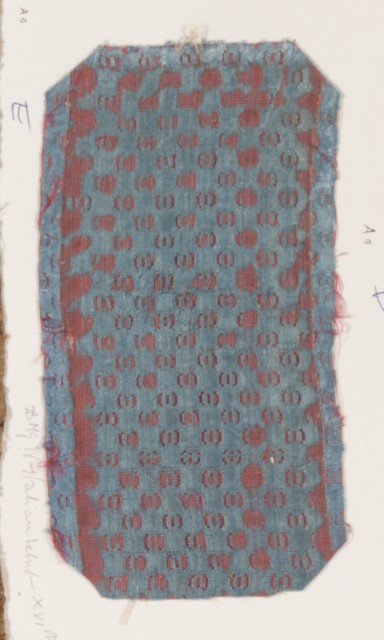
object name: fragment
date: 1501-1600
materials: silk